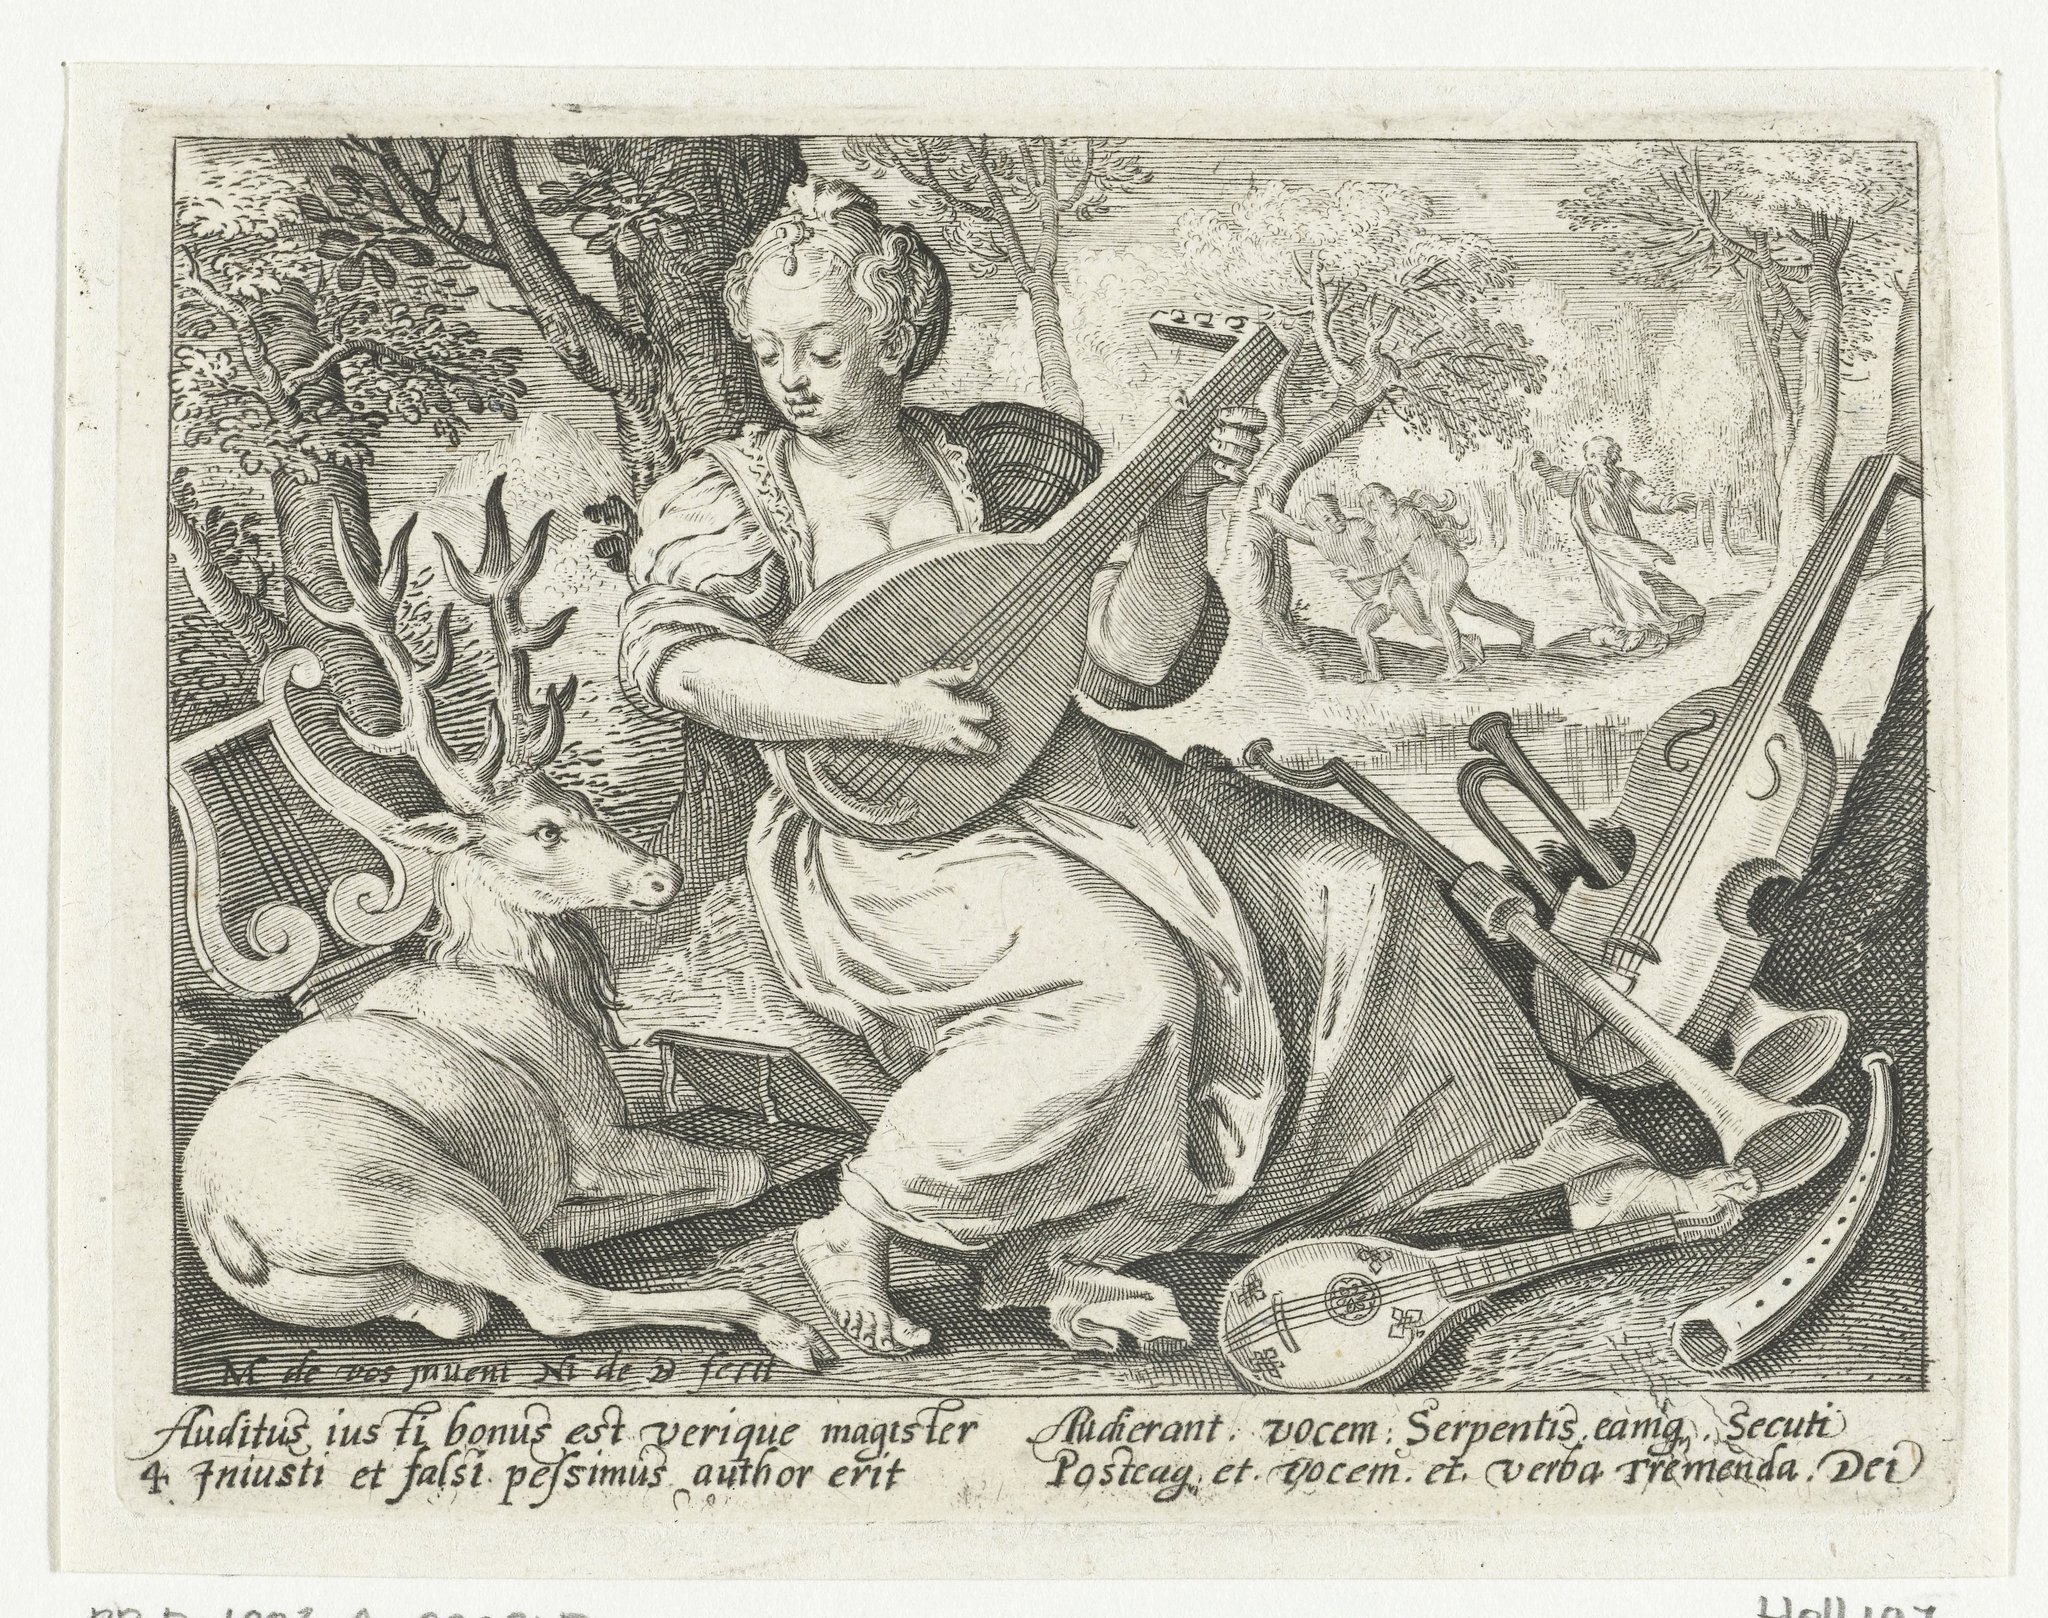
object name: print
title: Vijf zintuigen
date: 1581-1656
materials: paper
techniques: engraving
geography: netherlands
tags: hearing, listening (one of the five senses), hoofed animals: stag, adam and eve discover their nakedness; they cover themselves with their hands or with leaves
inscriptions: collector's mark: Lugt 2228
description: Vrouw als personificatie van zintuig gehoor zittend in landschap met instrumenten, zij speelt op een luit terwijl een edelhert naast haar ligt. Op de achtergrond is een scène uit Genesis weergegeven: Adam en Eva verbergen zich voor God uit schaamte. In marge onder twee regels Latijn.